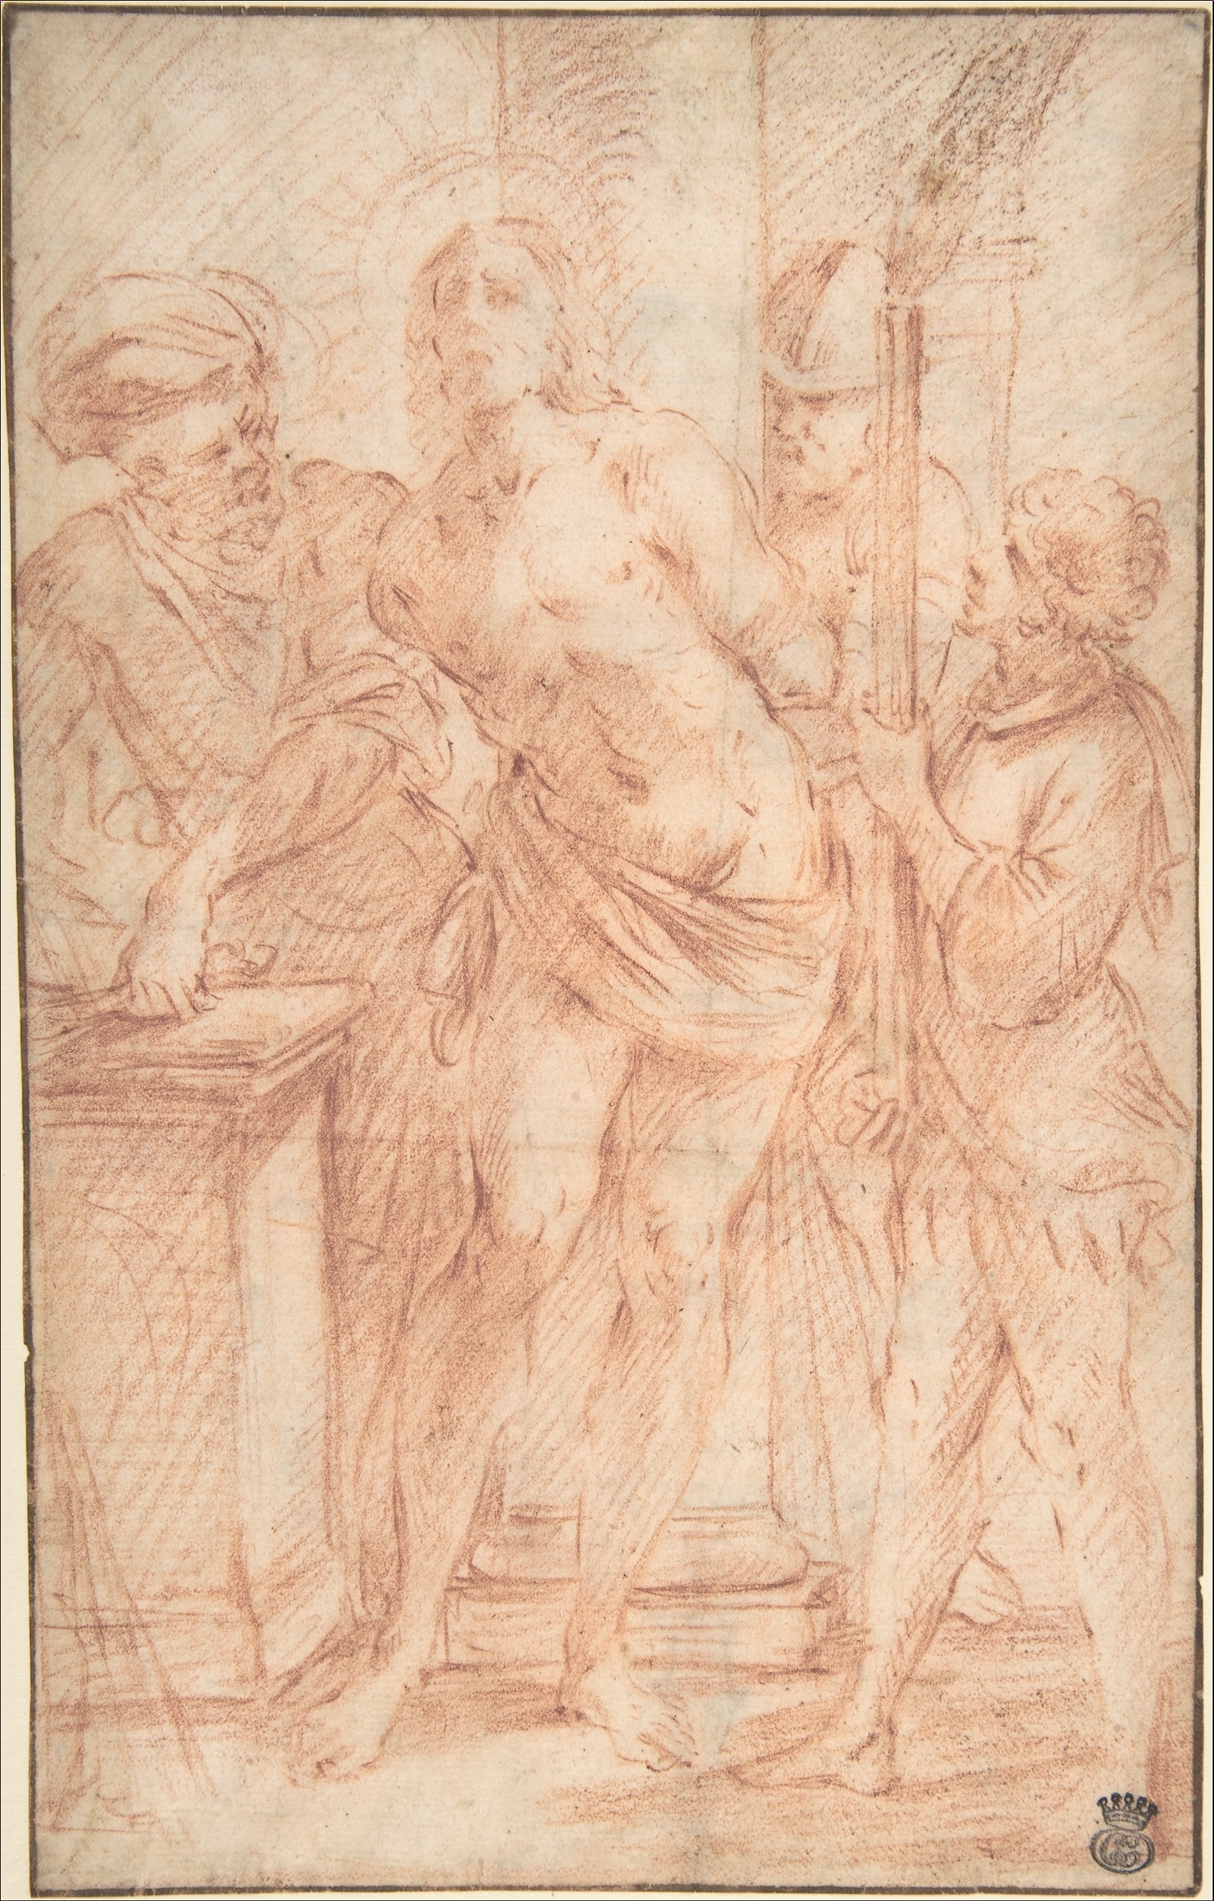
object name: drawing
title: The Mocking of Christ (recto); Exterior View of a Church (verso)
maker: anonymous, italian, roman-bolognese, 17th century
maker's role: artist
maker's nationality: italian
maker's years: 1600-1700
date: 1601-1700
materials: chalk, ink, paper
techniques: pen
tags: christ,cross